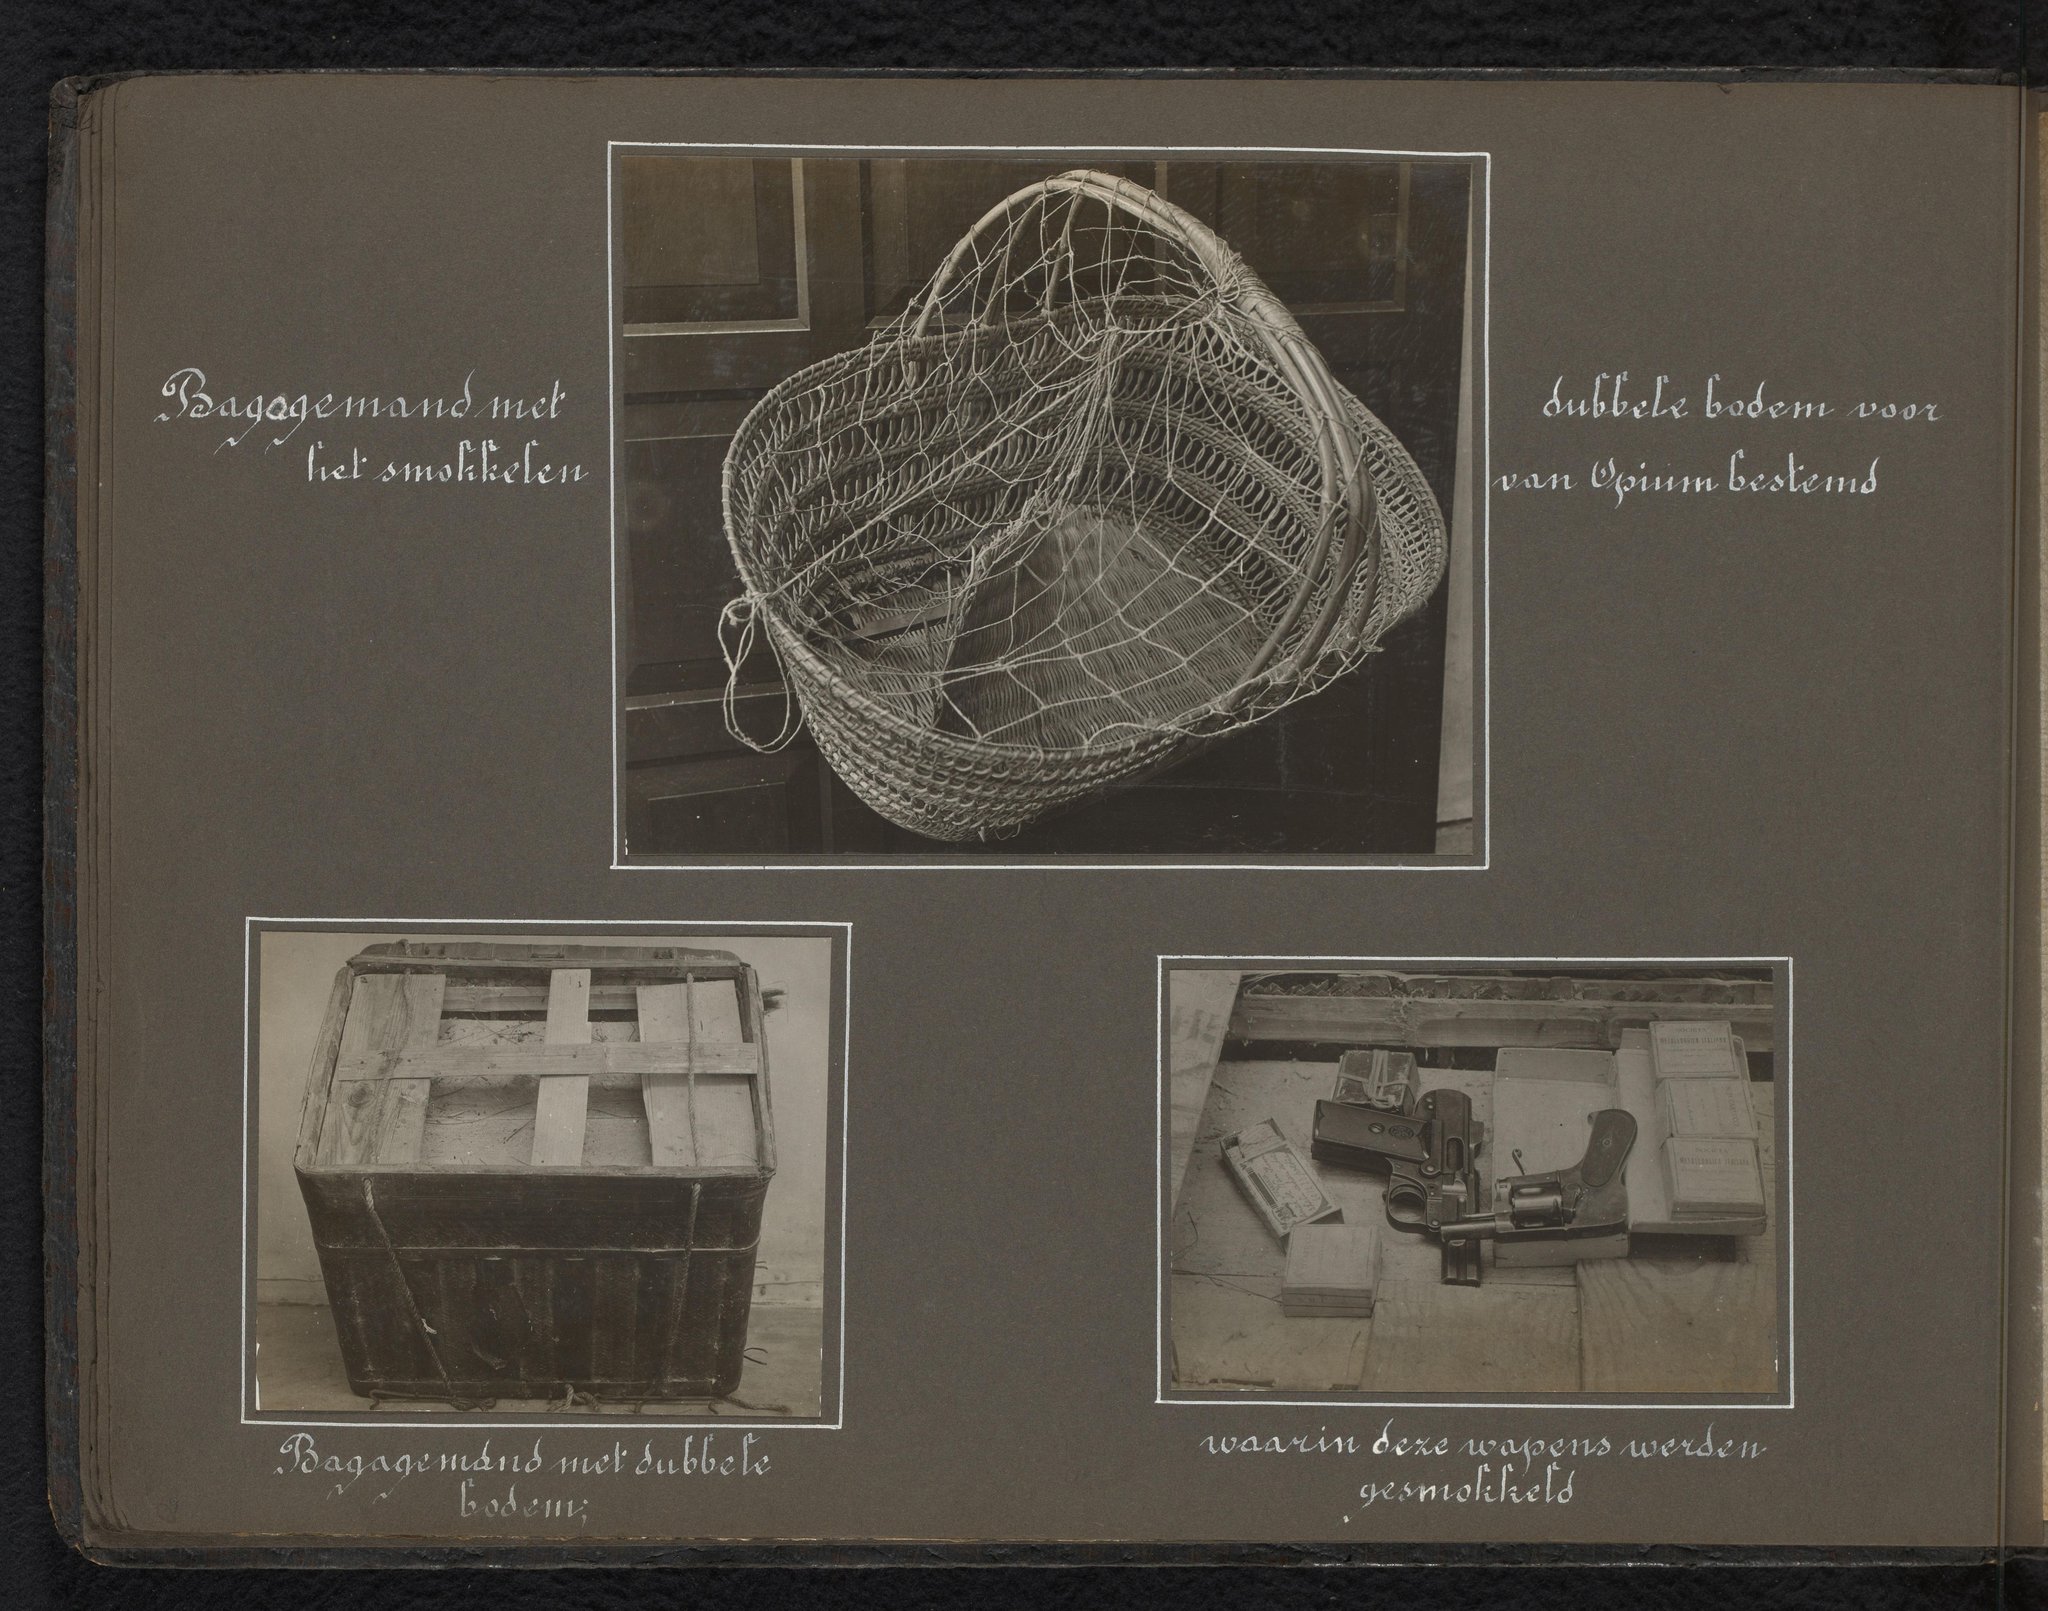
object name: album leaf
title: Mand en kist met dubbele bodems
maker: Anonymous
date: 1920-1930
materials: cardboard, photographic support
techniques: gelatin silver print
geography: dutch east indies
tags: opium, trade and smuggling of drugs, policeman, constable, dutch east indies, the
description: Albumblad met drie foto's van een mand en een kist, beide met een dubbele bodem voor het smokkelen van opium en wapens. Onderdeel van het fotoalbum uit 1930 met politiefoto's over de opiumsmokkel in Indië.